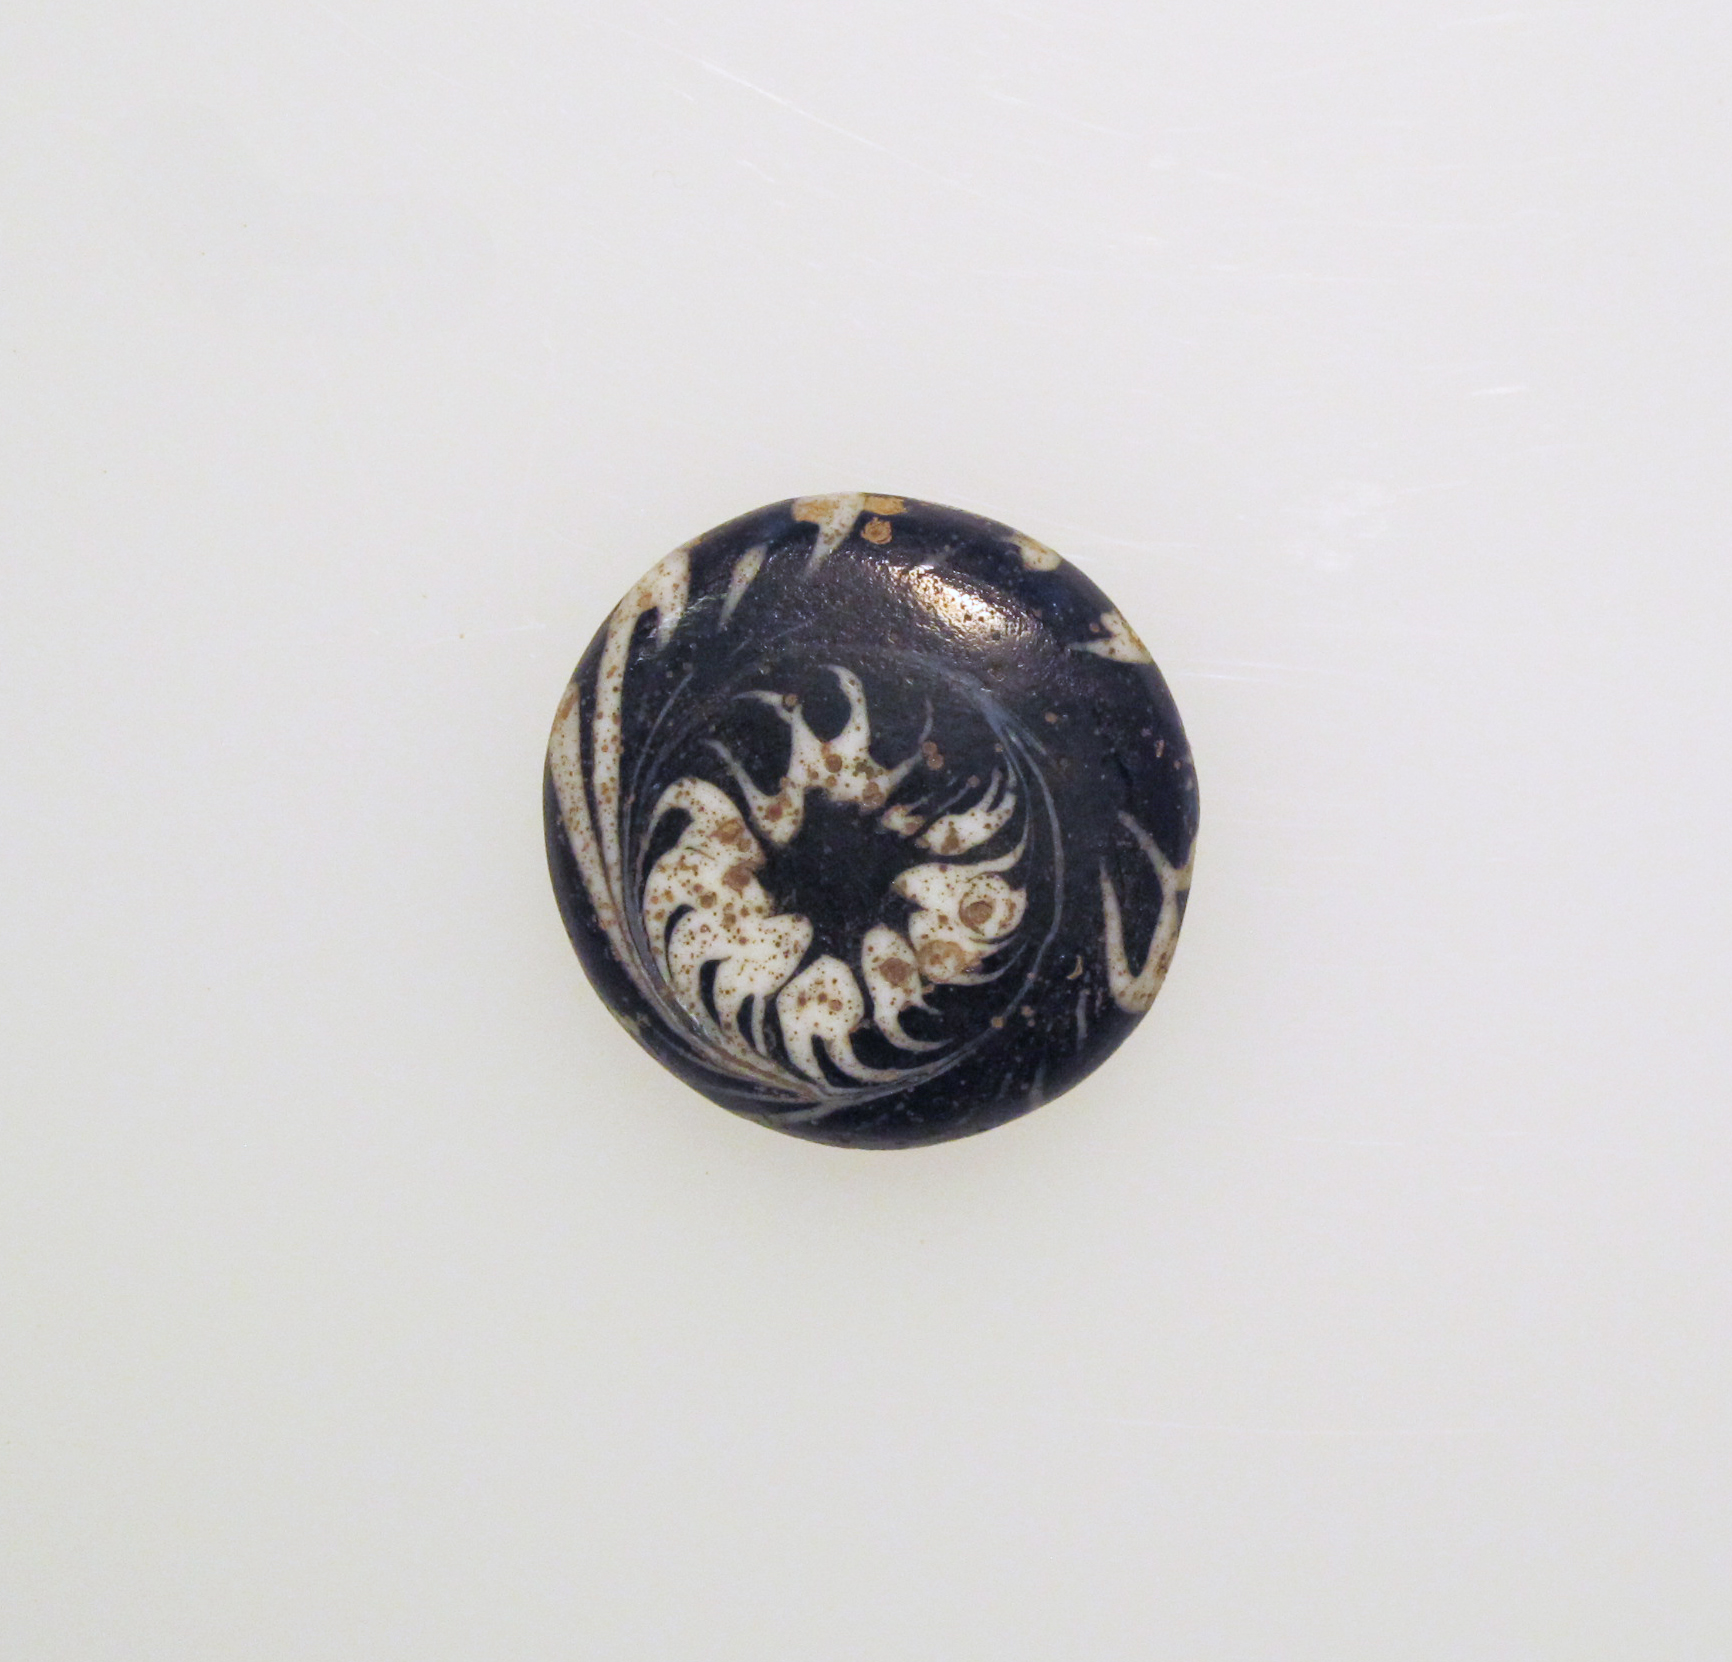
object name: pinhead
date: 7000 BCE-330 CE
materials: glass